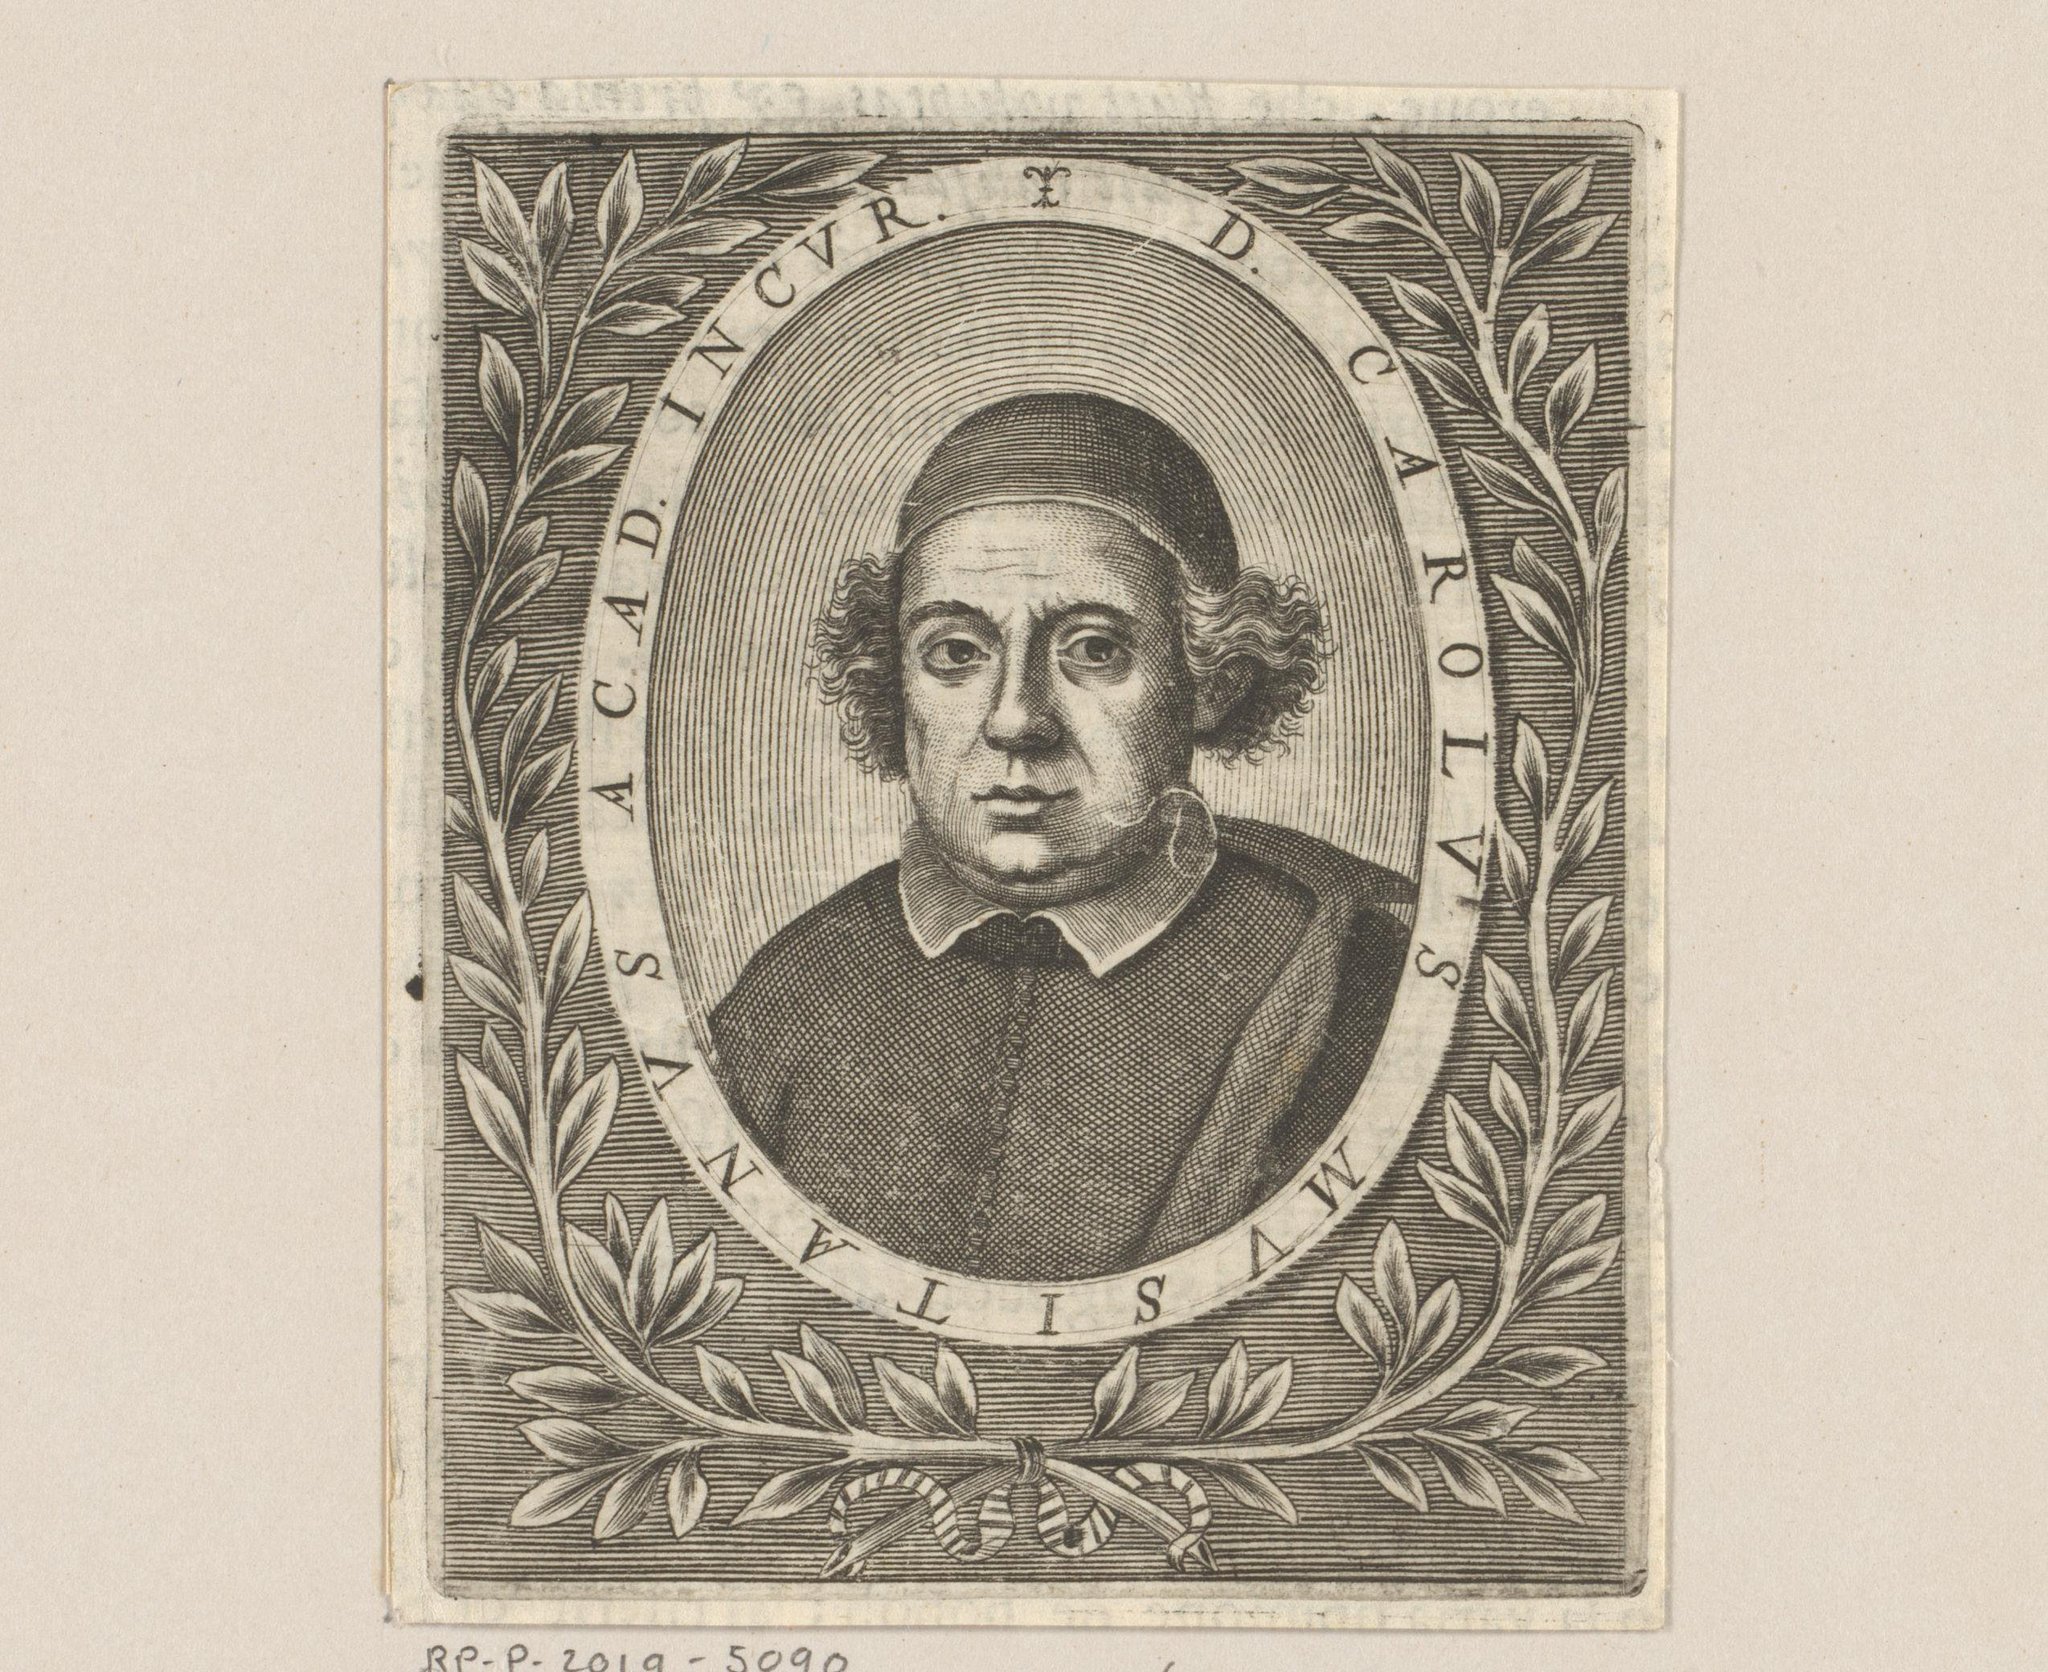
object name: book illustration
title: Portret van Carlo Musitano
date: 1703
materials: paper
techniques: engraving, etching, letterpress printing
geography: naples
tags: castrovillari, naples, clergyman, historical persons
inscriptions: collector's mark: Lugt 2228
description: Prent uit: Gimma, Giacinto. Elogj accademici della Società degli Spensierati di Rossano (...). Napels: Carlo Troise, 1703, p. 99.